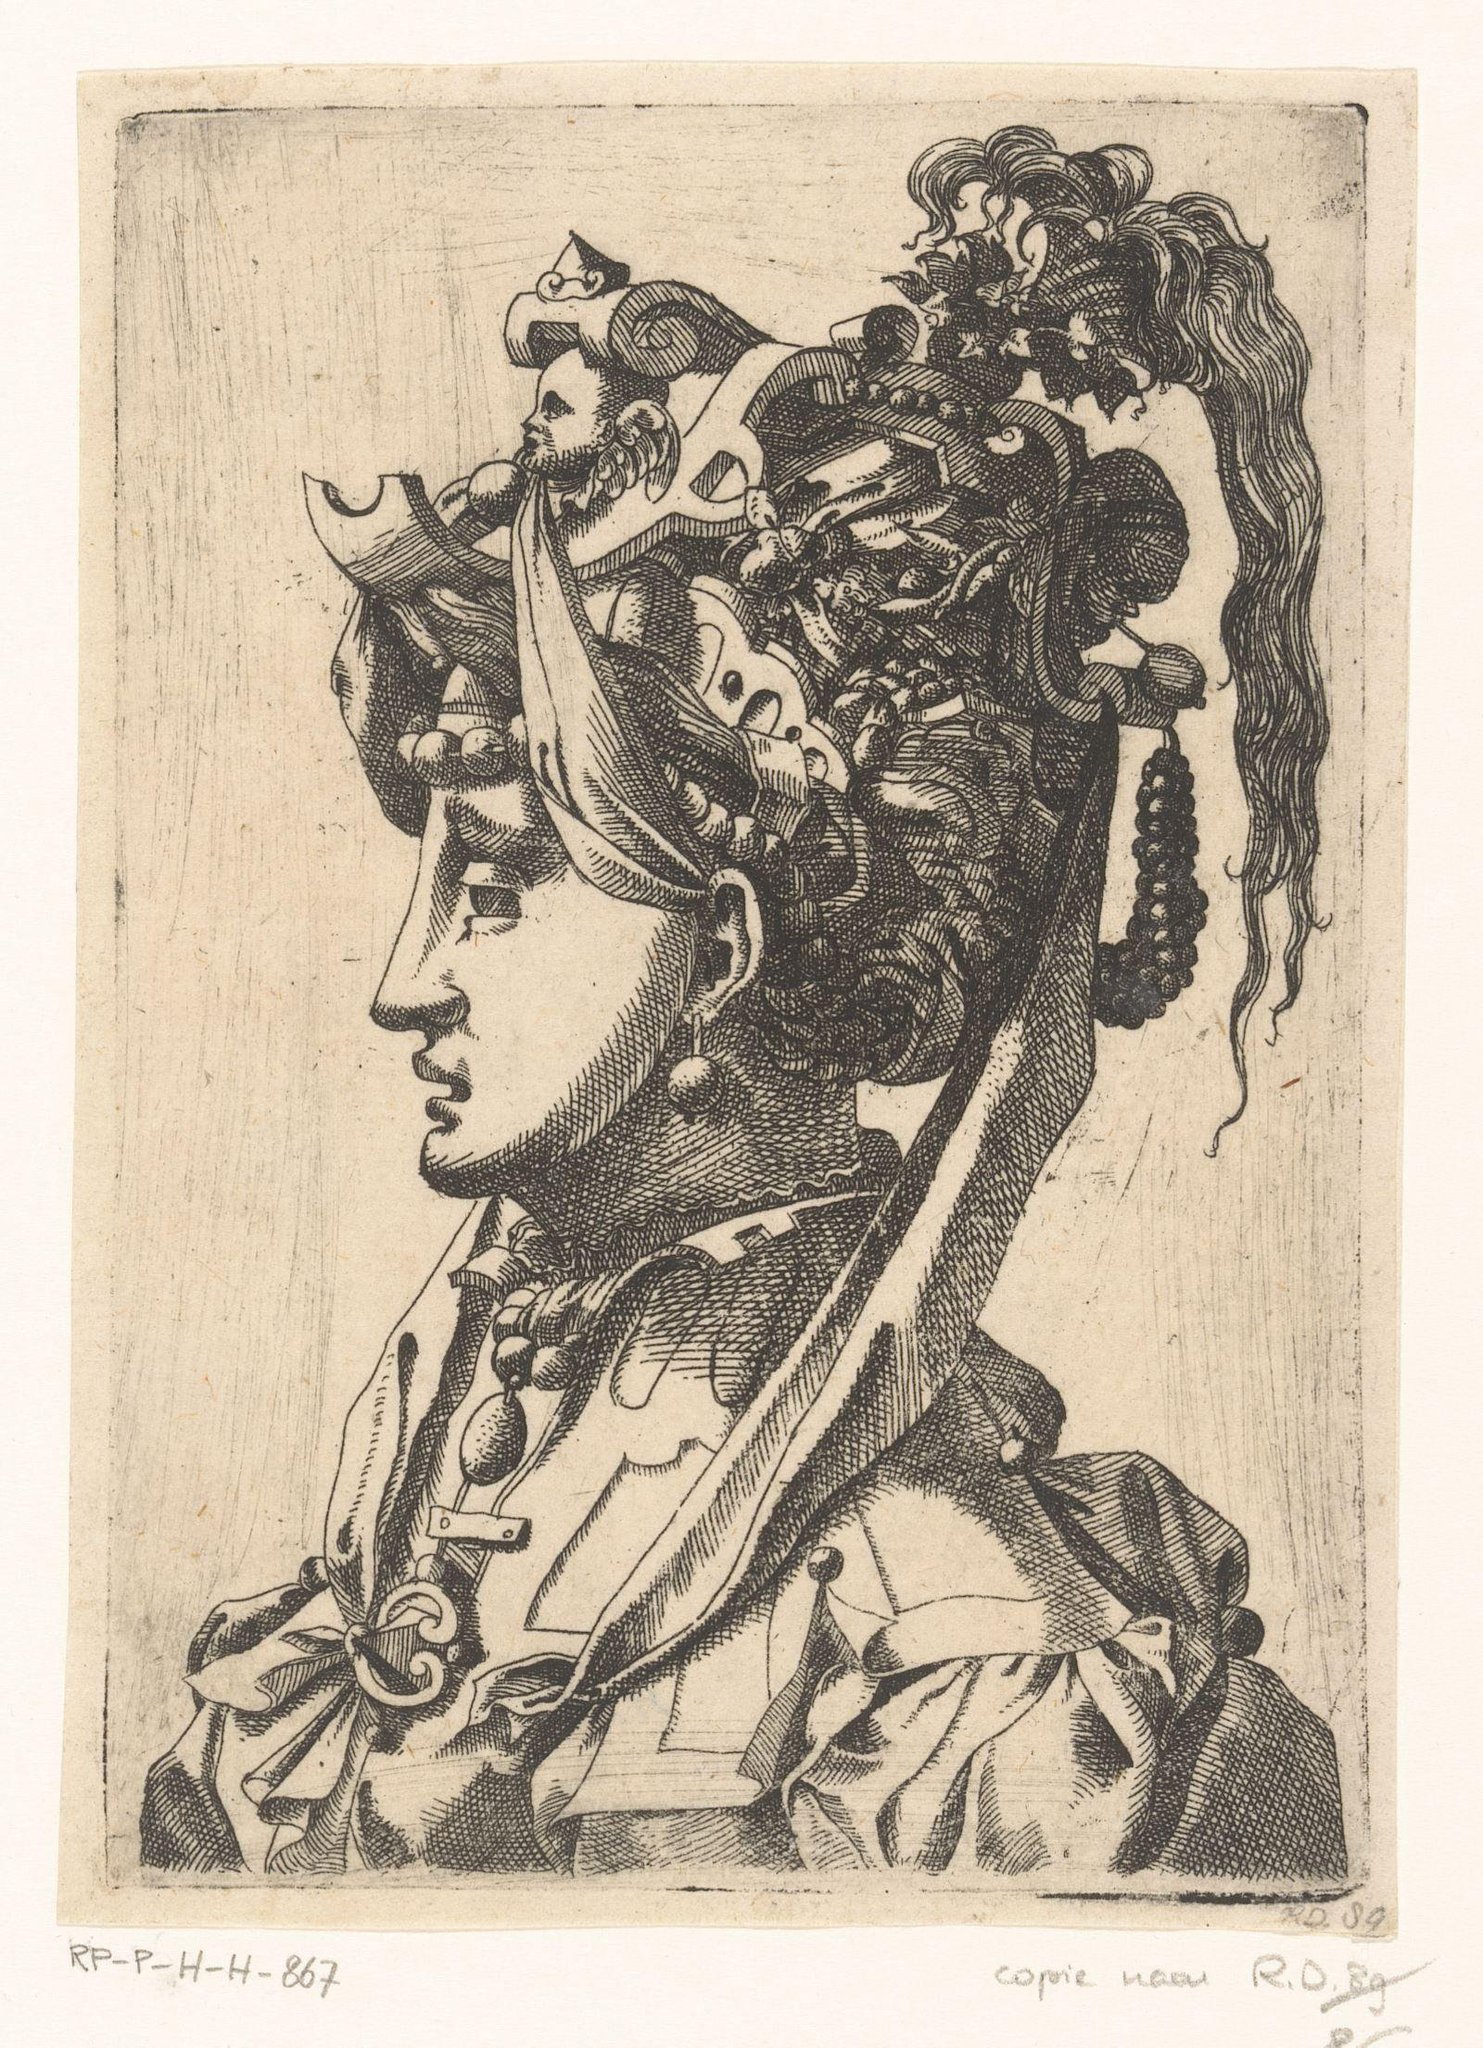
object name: print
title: Vrouw met masker en fantasie hoofdbedekking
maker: Anonymous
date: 1535-1598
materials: paper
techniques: etching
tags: mask, head-gear, the arts of the stage: ballet, theatre, musical drama, motion picture, fantasy costume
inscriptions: collector's mark: Lugt 11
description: Kopie naar een prent uit een serie van twaalf prenten met mannen- en vrouwenkostuums en haardrachten voor het ballet, getiteld 'Coiffures ou masques d'hommes et de femmes pour des ballets', naar ontwerp door Rosso Fiorentino. Betreft een spiegelbeeldige kopie naar de linkerhelft van Dumesnil 86.